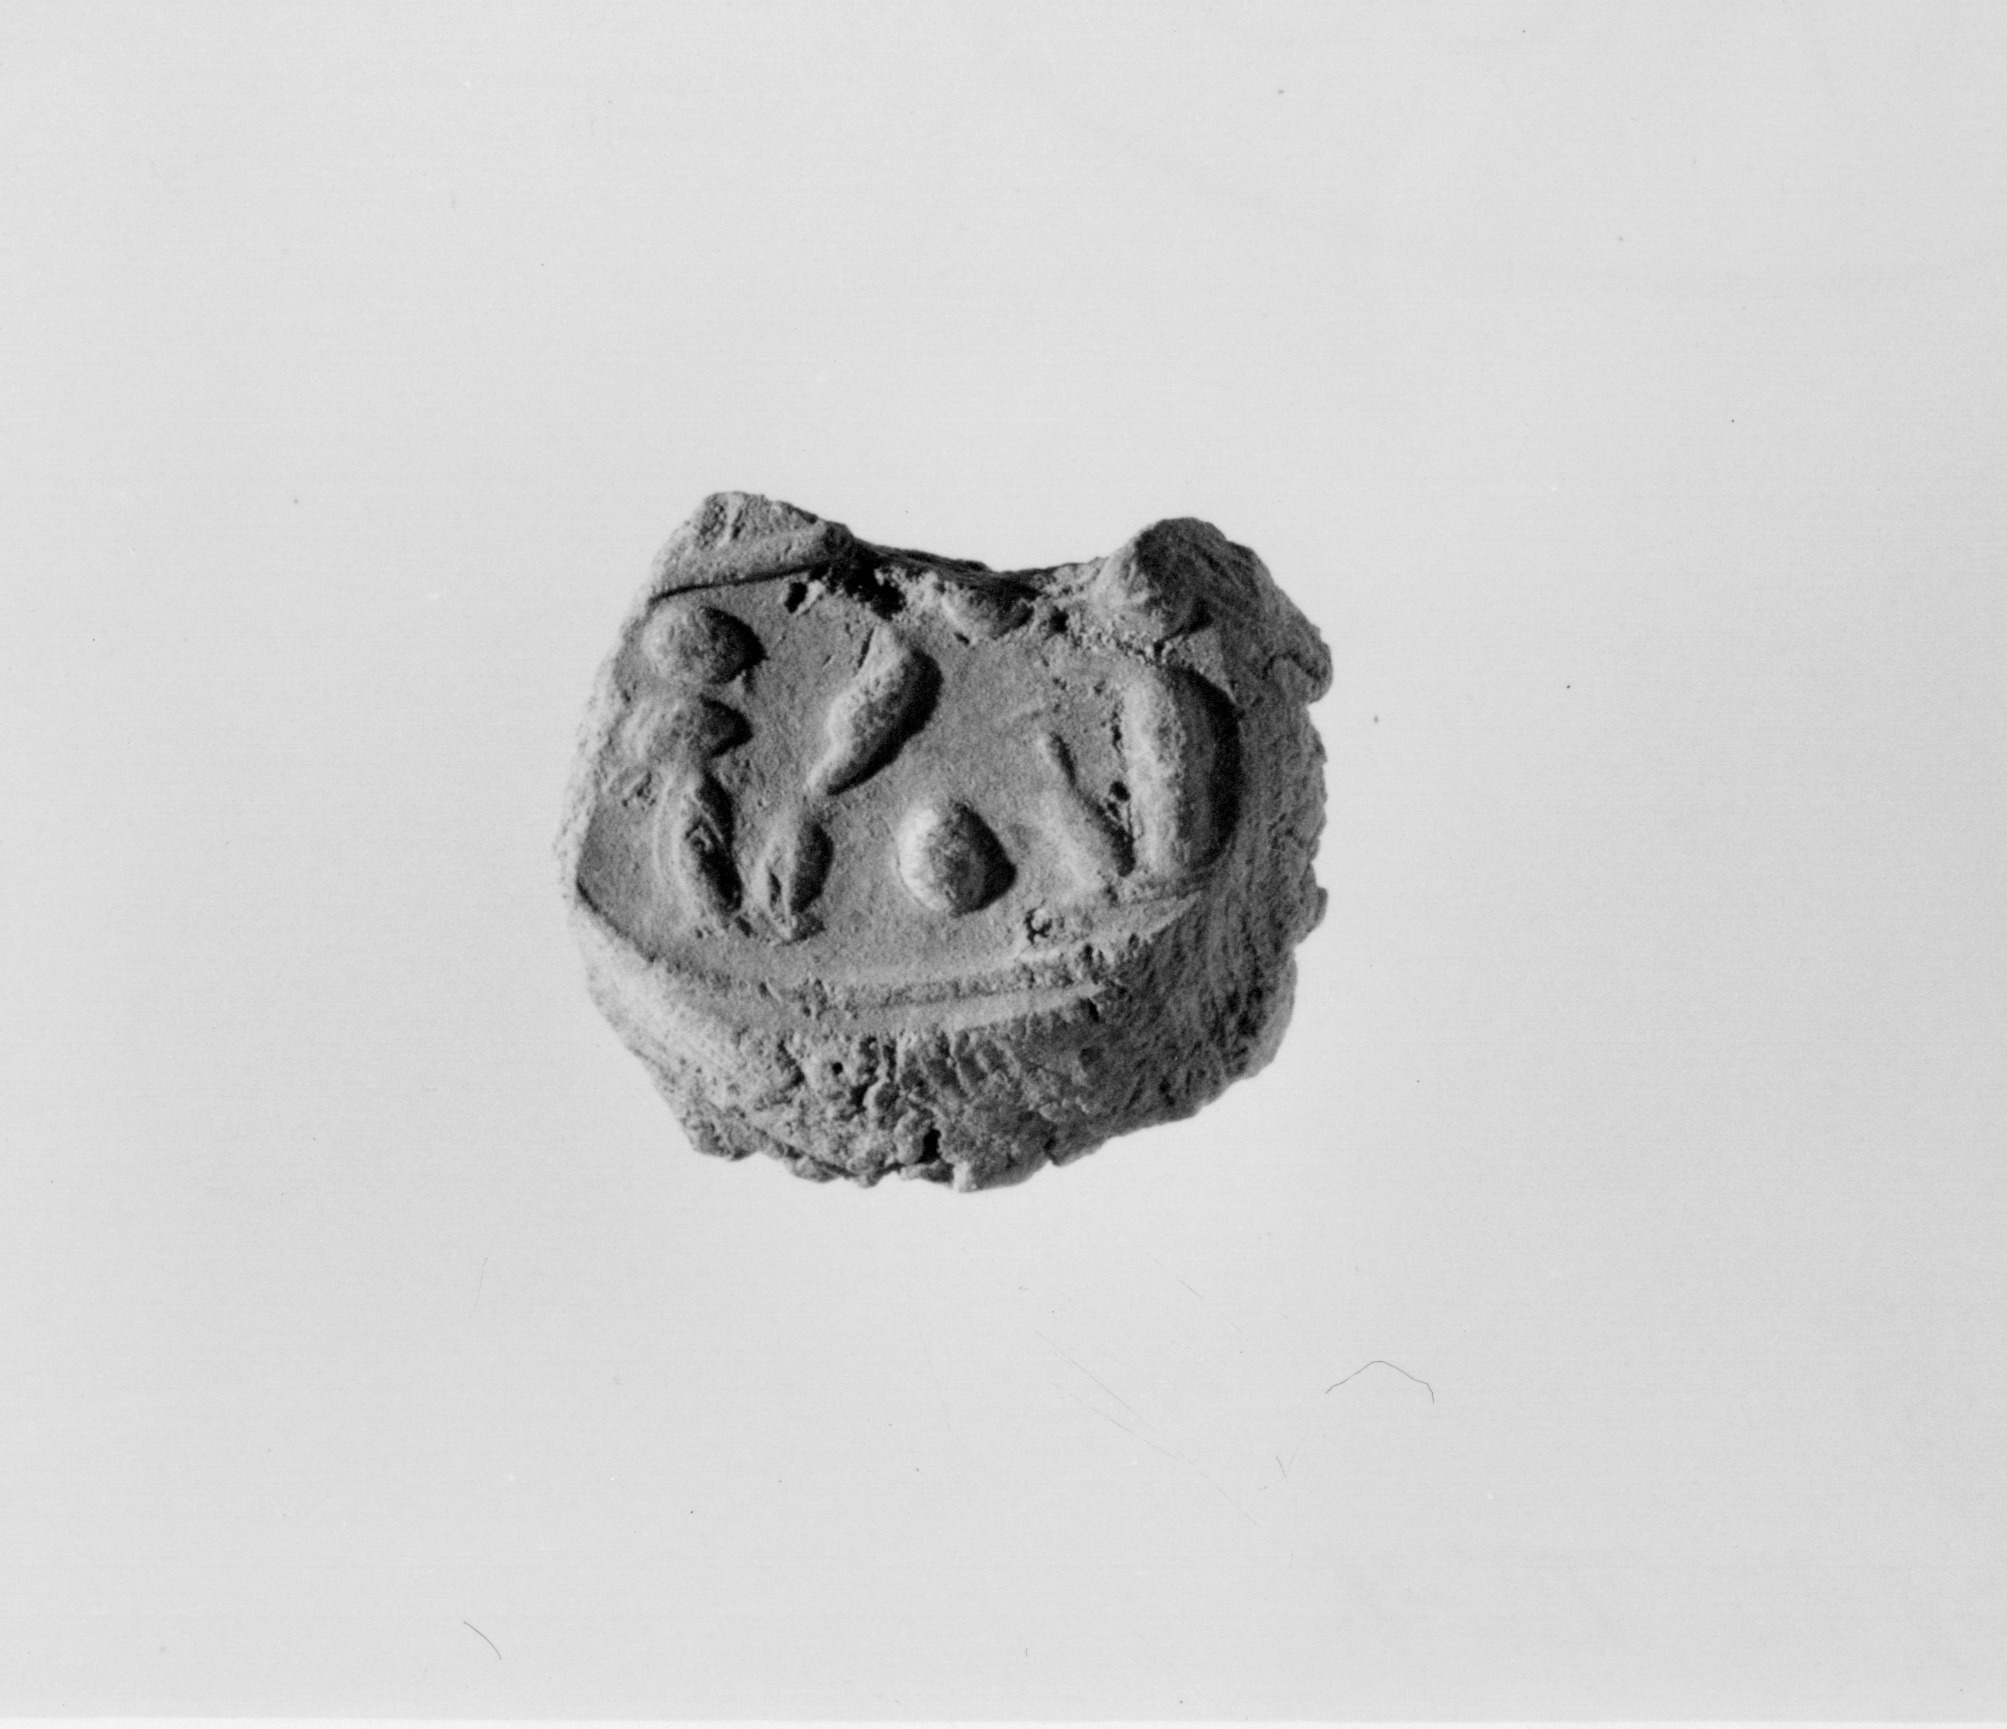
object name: sealing, nebmaatre, amenhotep iii, sobek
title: Document Sealing With the Throne Name of Amenhotep III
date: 1390-1352 BCE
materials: mud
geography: egypt